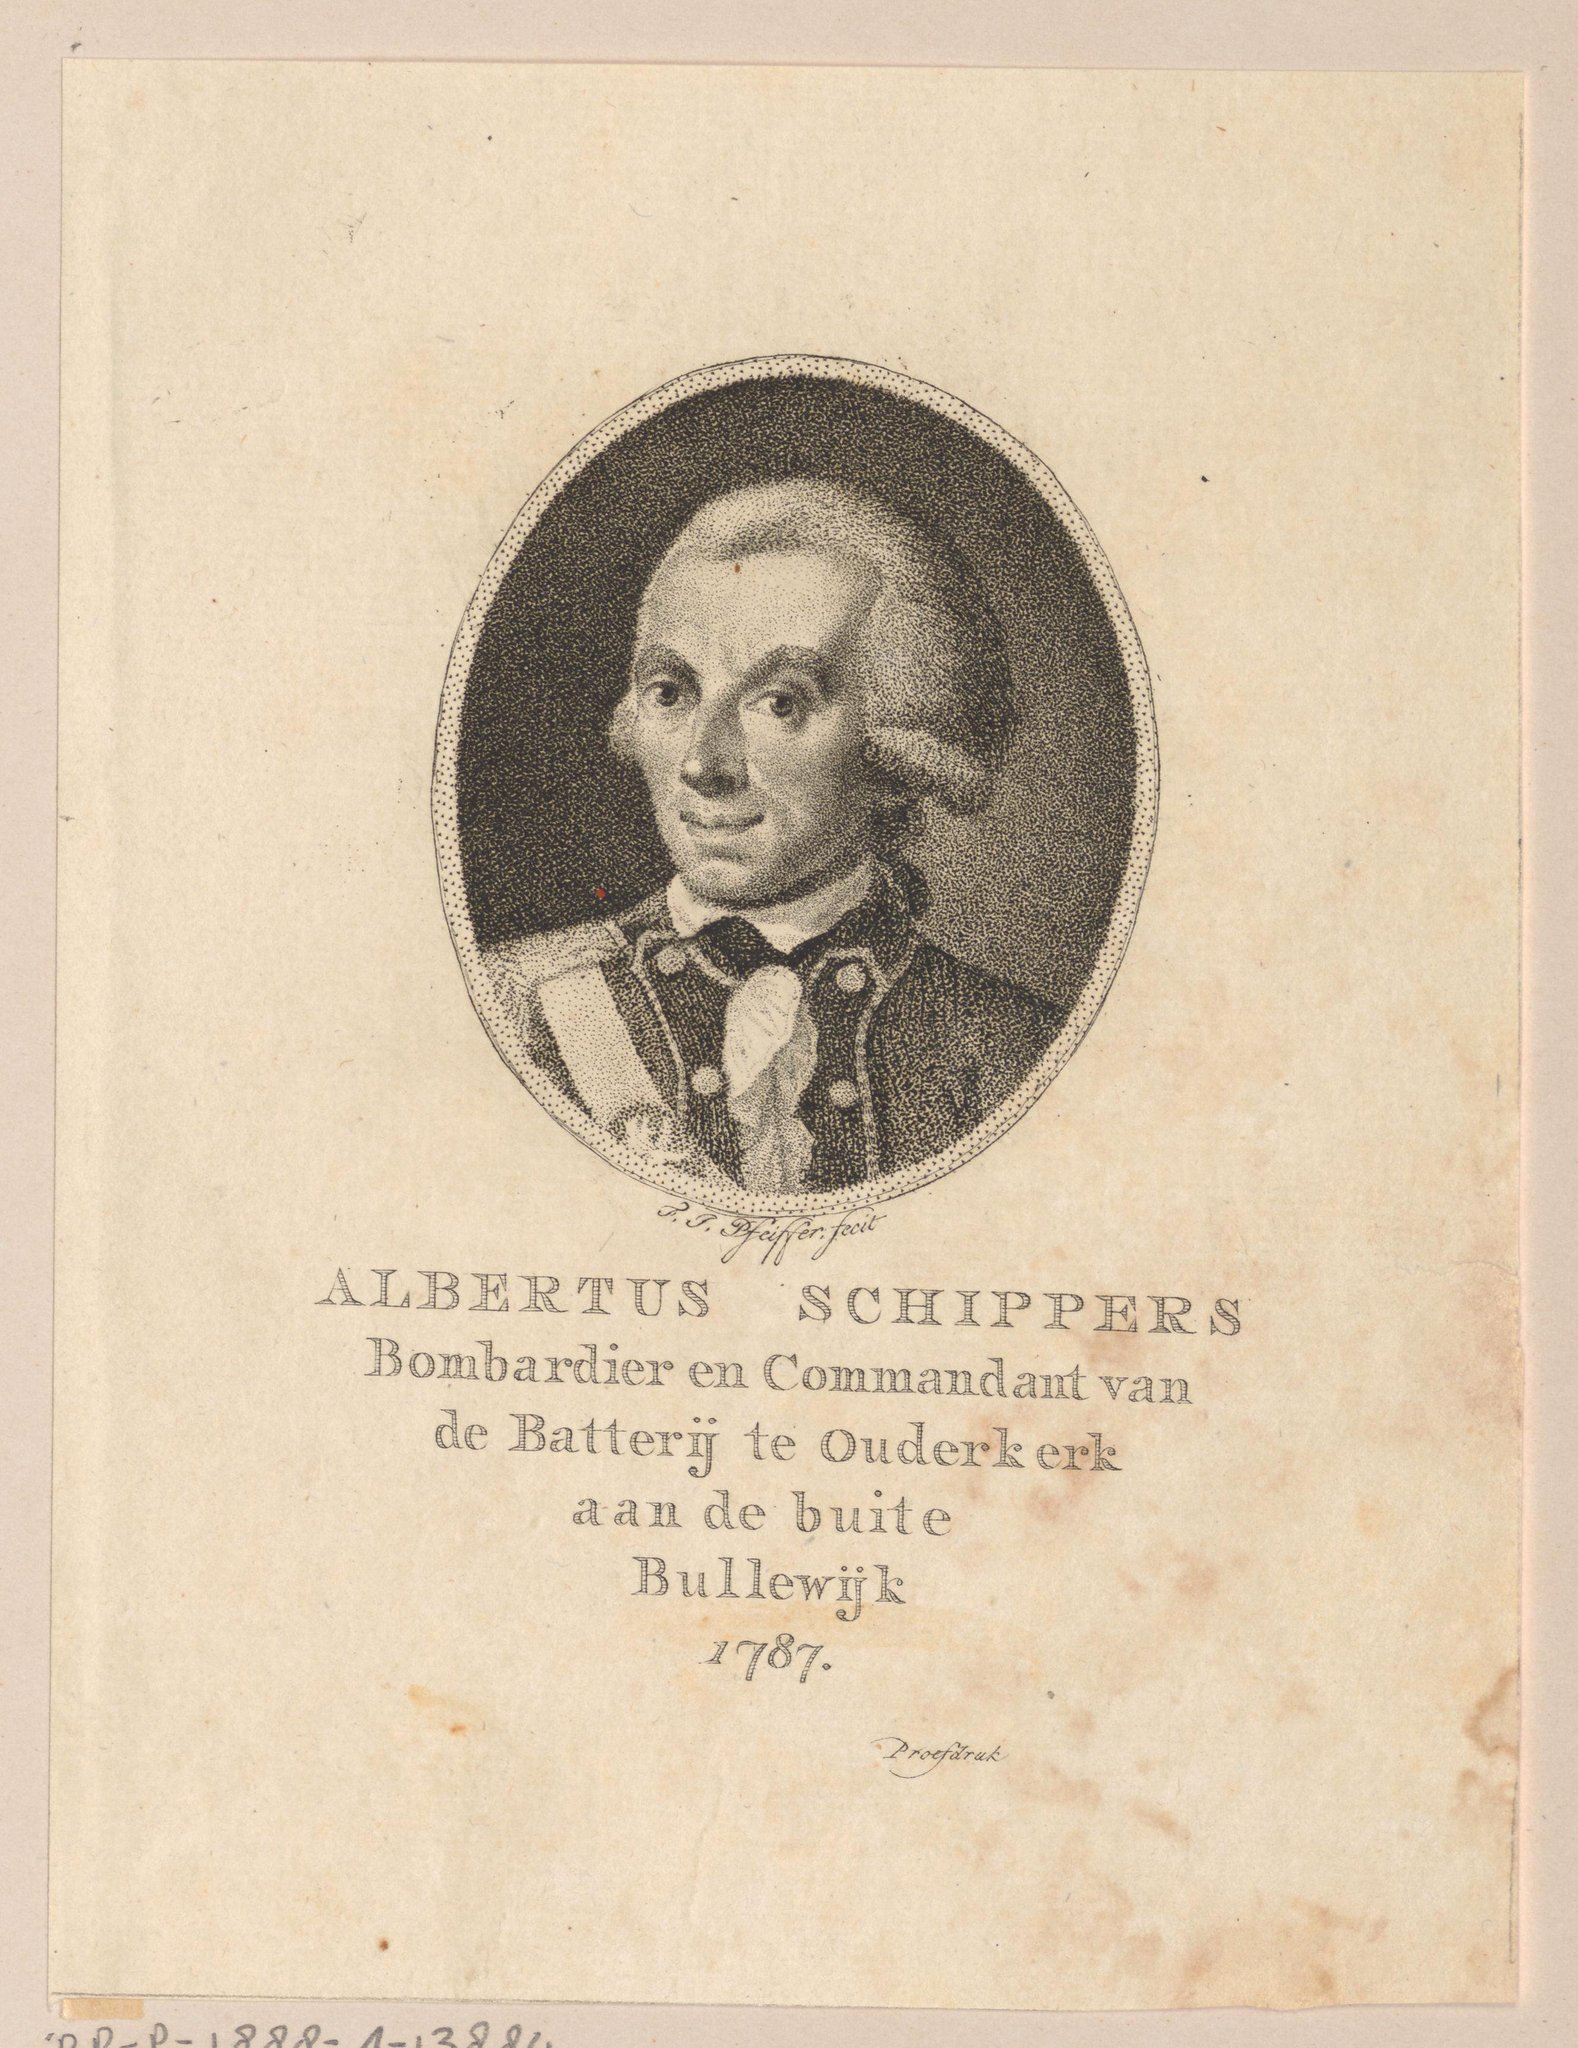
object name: print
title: Portret van Albertus Schippers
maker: françois joseph pfeiffer (i)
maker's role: print maker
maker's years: 1741-1807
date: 1787-1796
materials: paper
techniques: etching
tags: commander-in-chief, general, marshal, historical persons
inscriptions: collector's mark: Lugt 2228